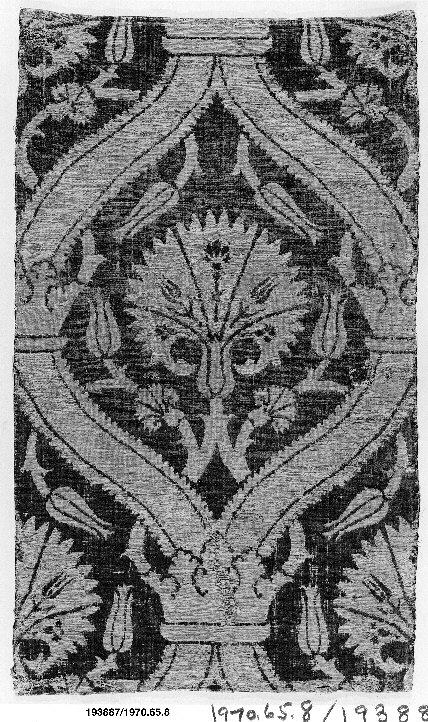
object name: textile fragment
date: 1501-1700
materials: hemp, metal, silk, thread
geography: turkey